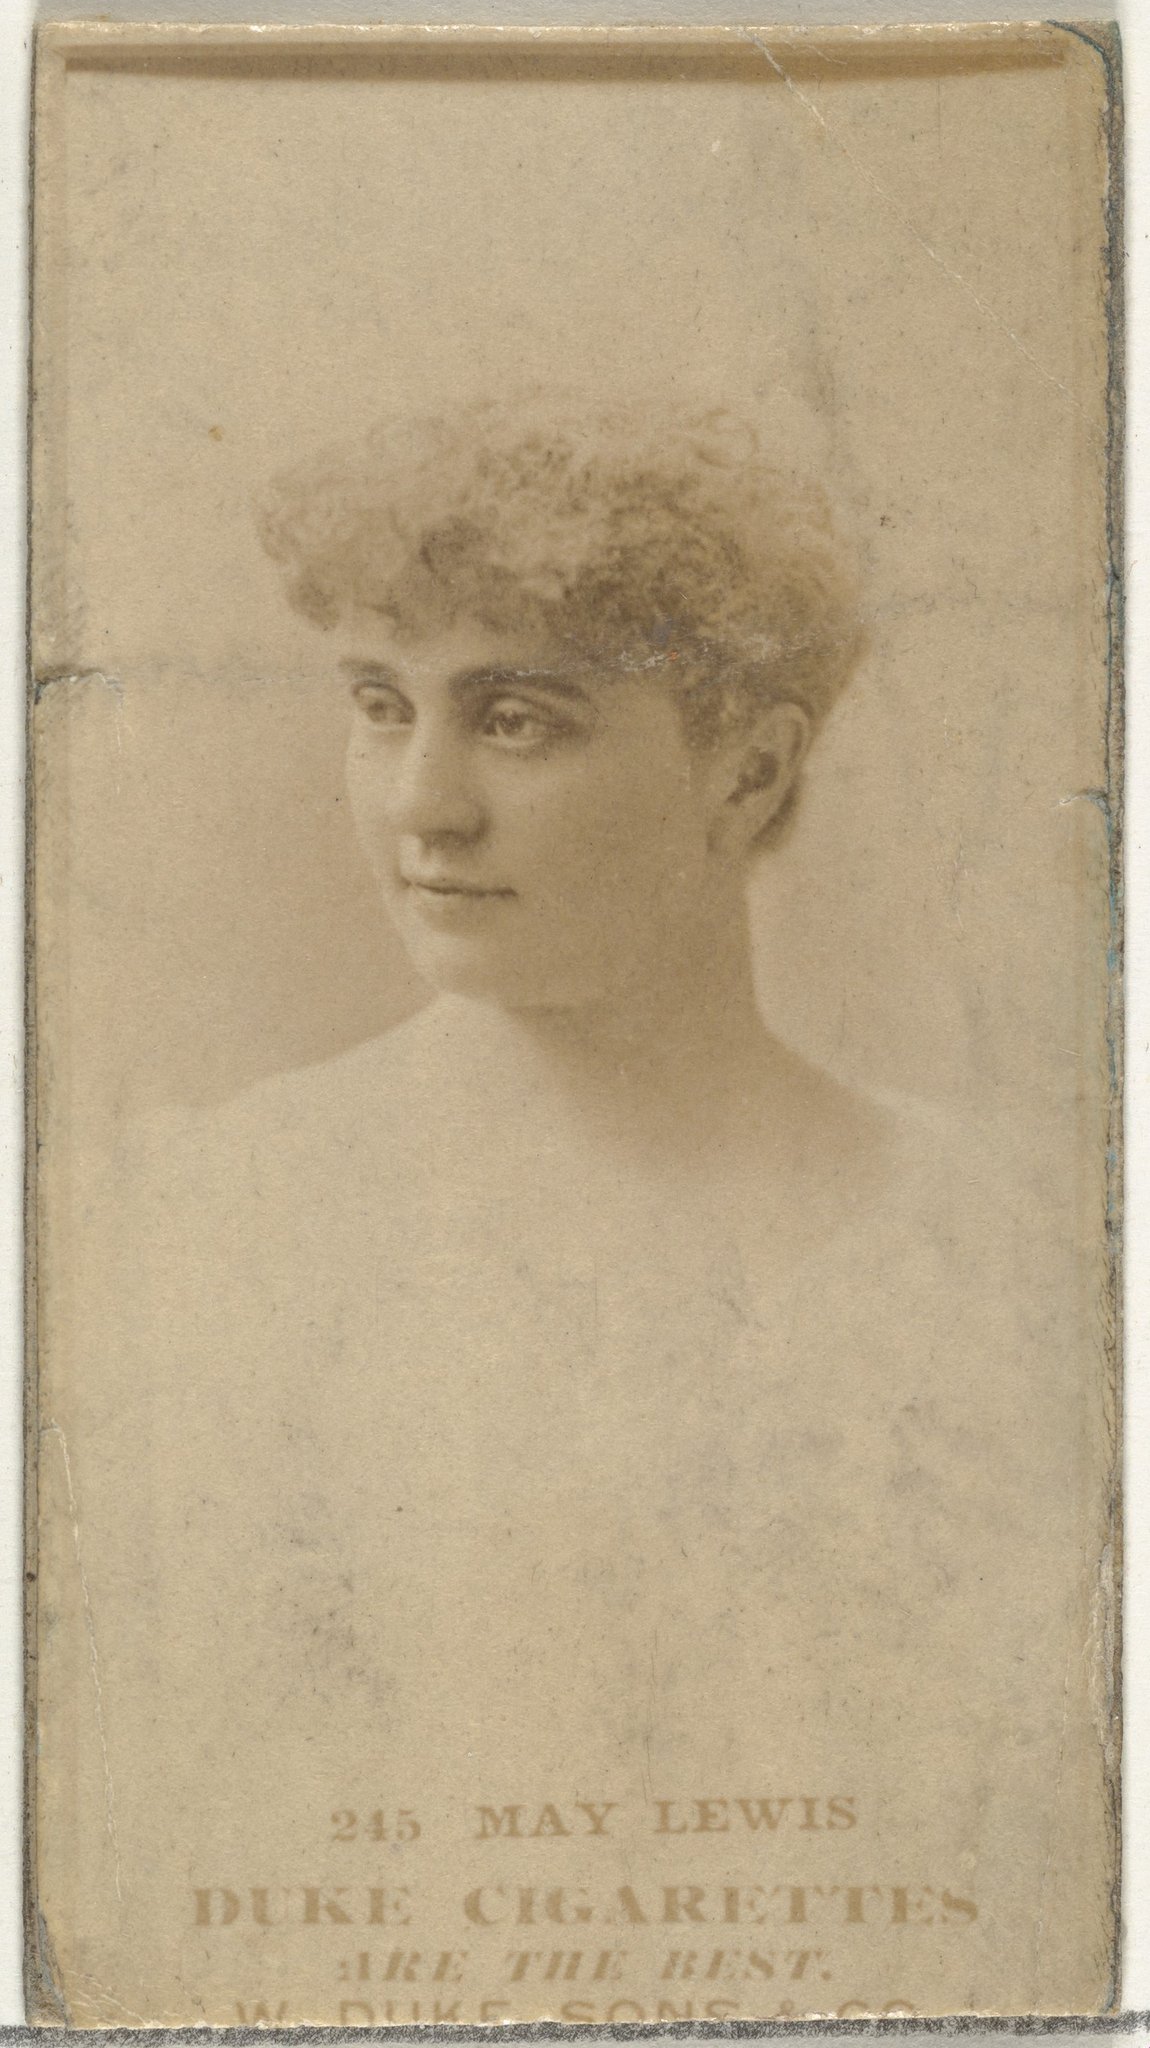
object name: photograph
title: Card Number 245, May Lewis, from the Actors and Actresses series (N145-7) issued by Duke Sons & Co. to promote Duke Cigarettes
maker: w. duke, sons & co.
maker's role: publisher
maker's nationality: american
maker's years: 1870-1920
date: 1880-1889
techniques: albumen silver print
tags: portraits,women,actresses